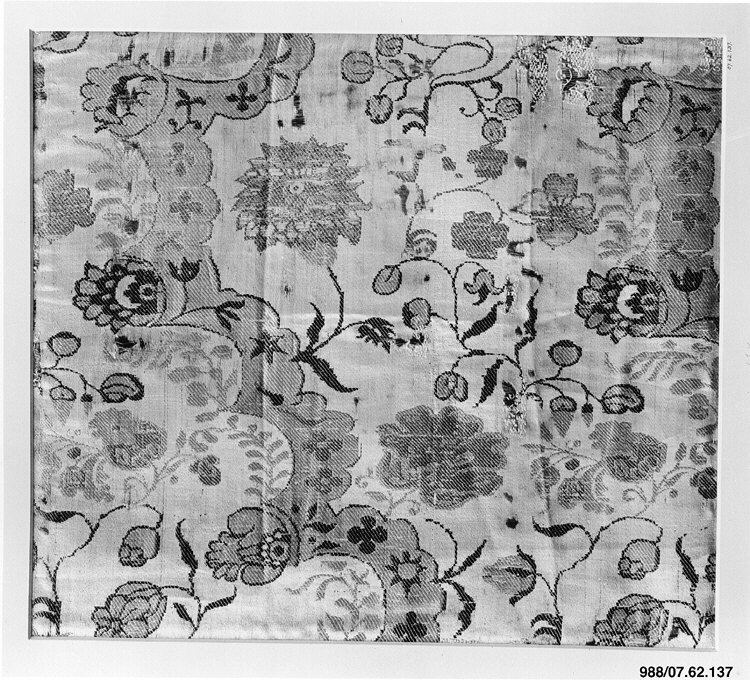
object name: piece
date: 1701-1800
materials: silk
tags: flowers,leaves